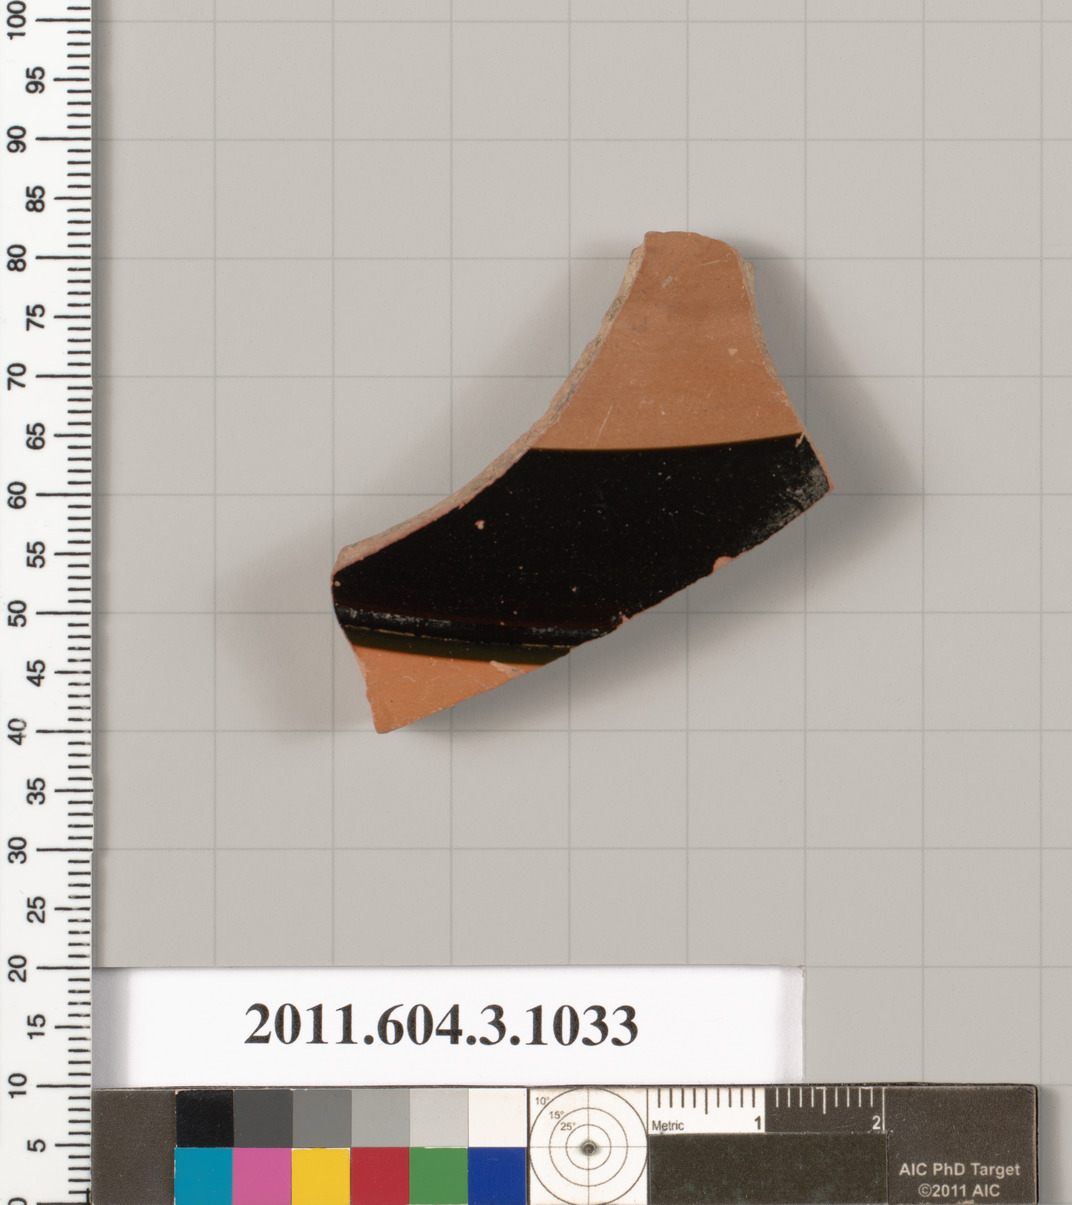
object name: phiale fragment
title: Terracotta fragment of a phiale (libation bowl)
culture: greek, attic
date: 600-501 BCE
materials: terracotta